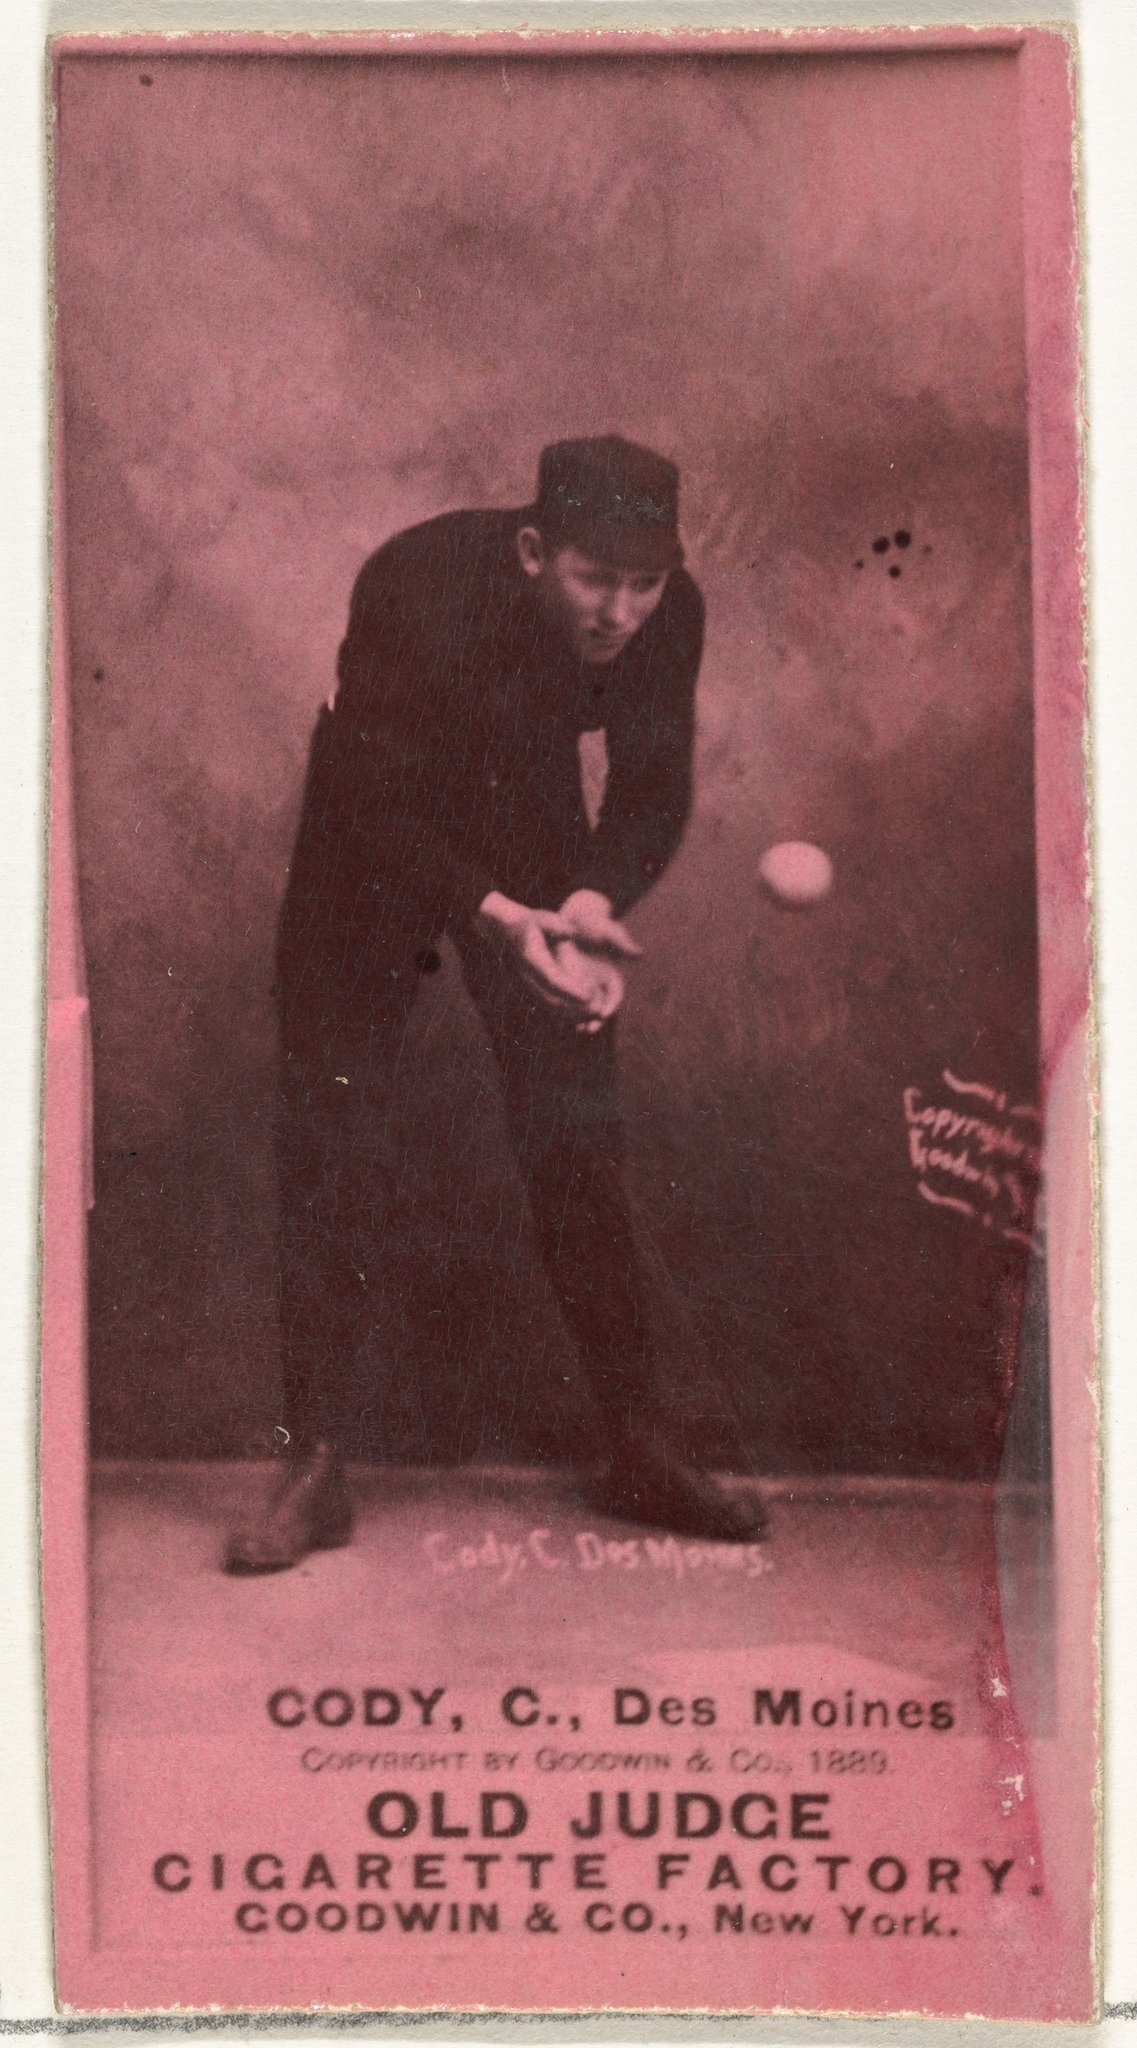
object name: baseball card, photograph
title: Michael J. Cody, Catcher, Des Moines Prohibitionists, from the Old Judge series (N172) for Old Judge Cigarettes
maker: goodwin & company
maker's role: publisher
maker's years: 1850-1950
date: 1889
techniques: albumen silver print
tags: men,portraits,baseball,athletes